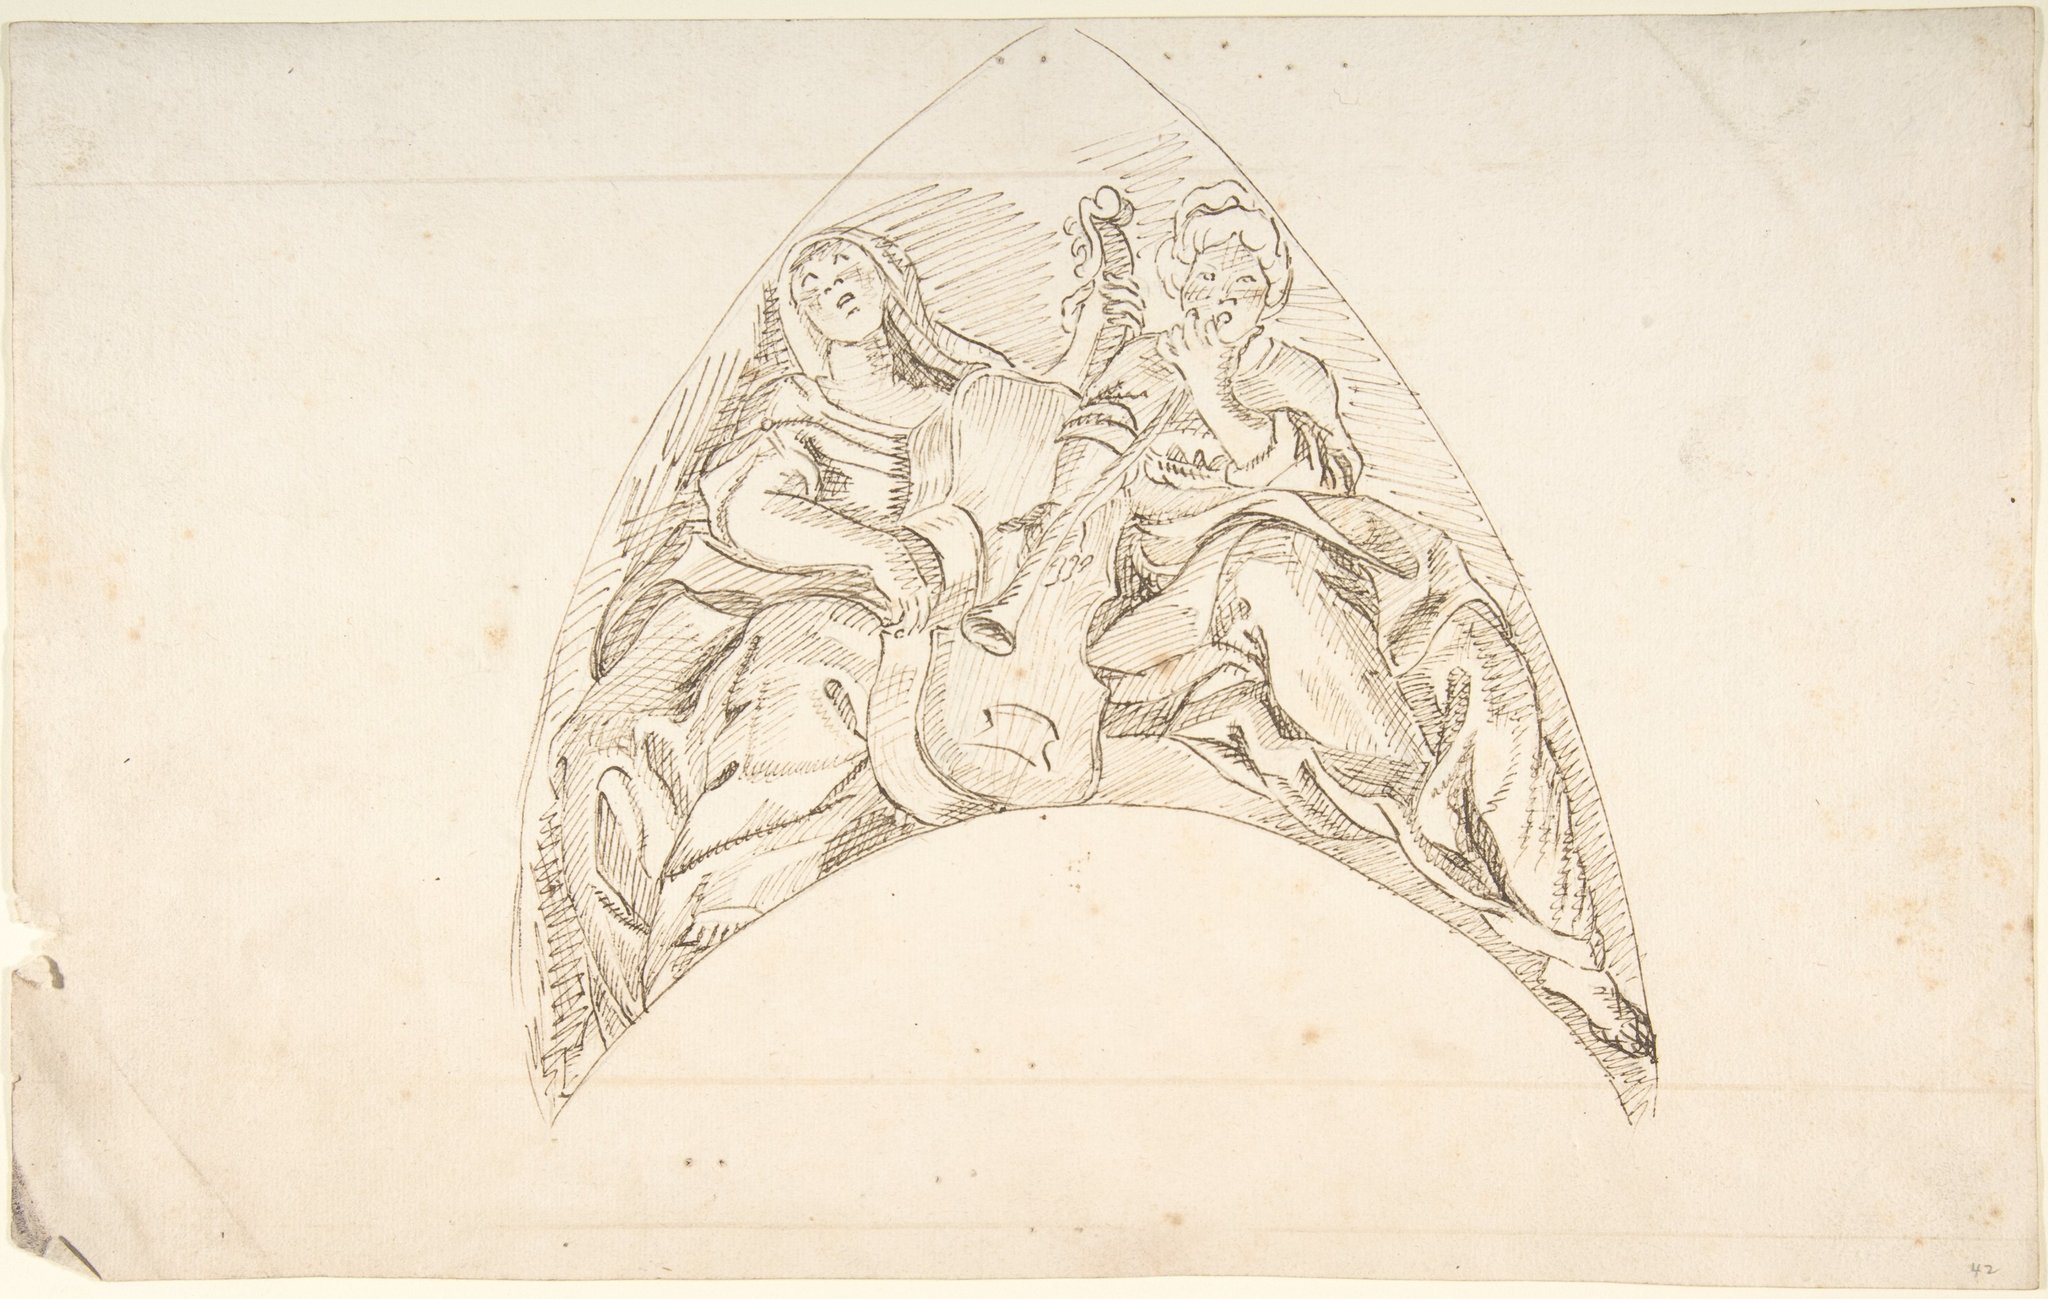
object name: drawing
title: Design for a Pedentive Decoration: two women with musical instruments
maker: anonymous, italian, piedmontese, 18th century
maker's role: artist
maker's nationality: italian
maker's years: 1700-1800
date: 1701-1800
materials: ink, drawing material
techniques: pen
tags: musical instruments,women